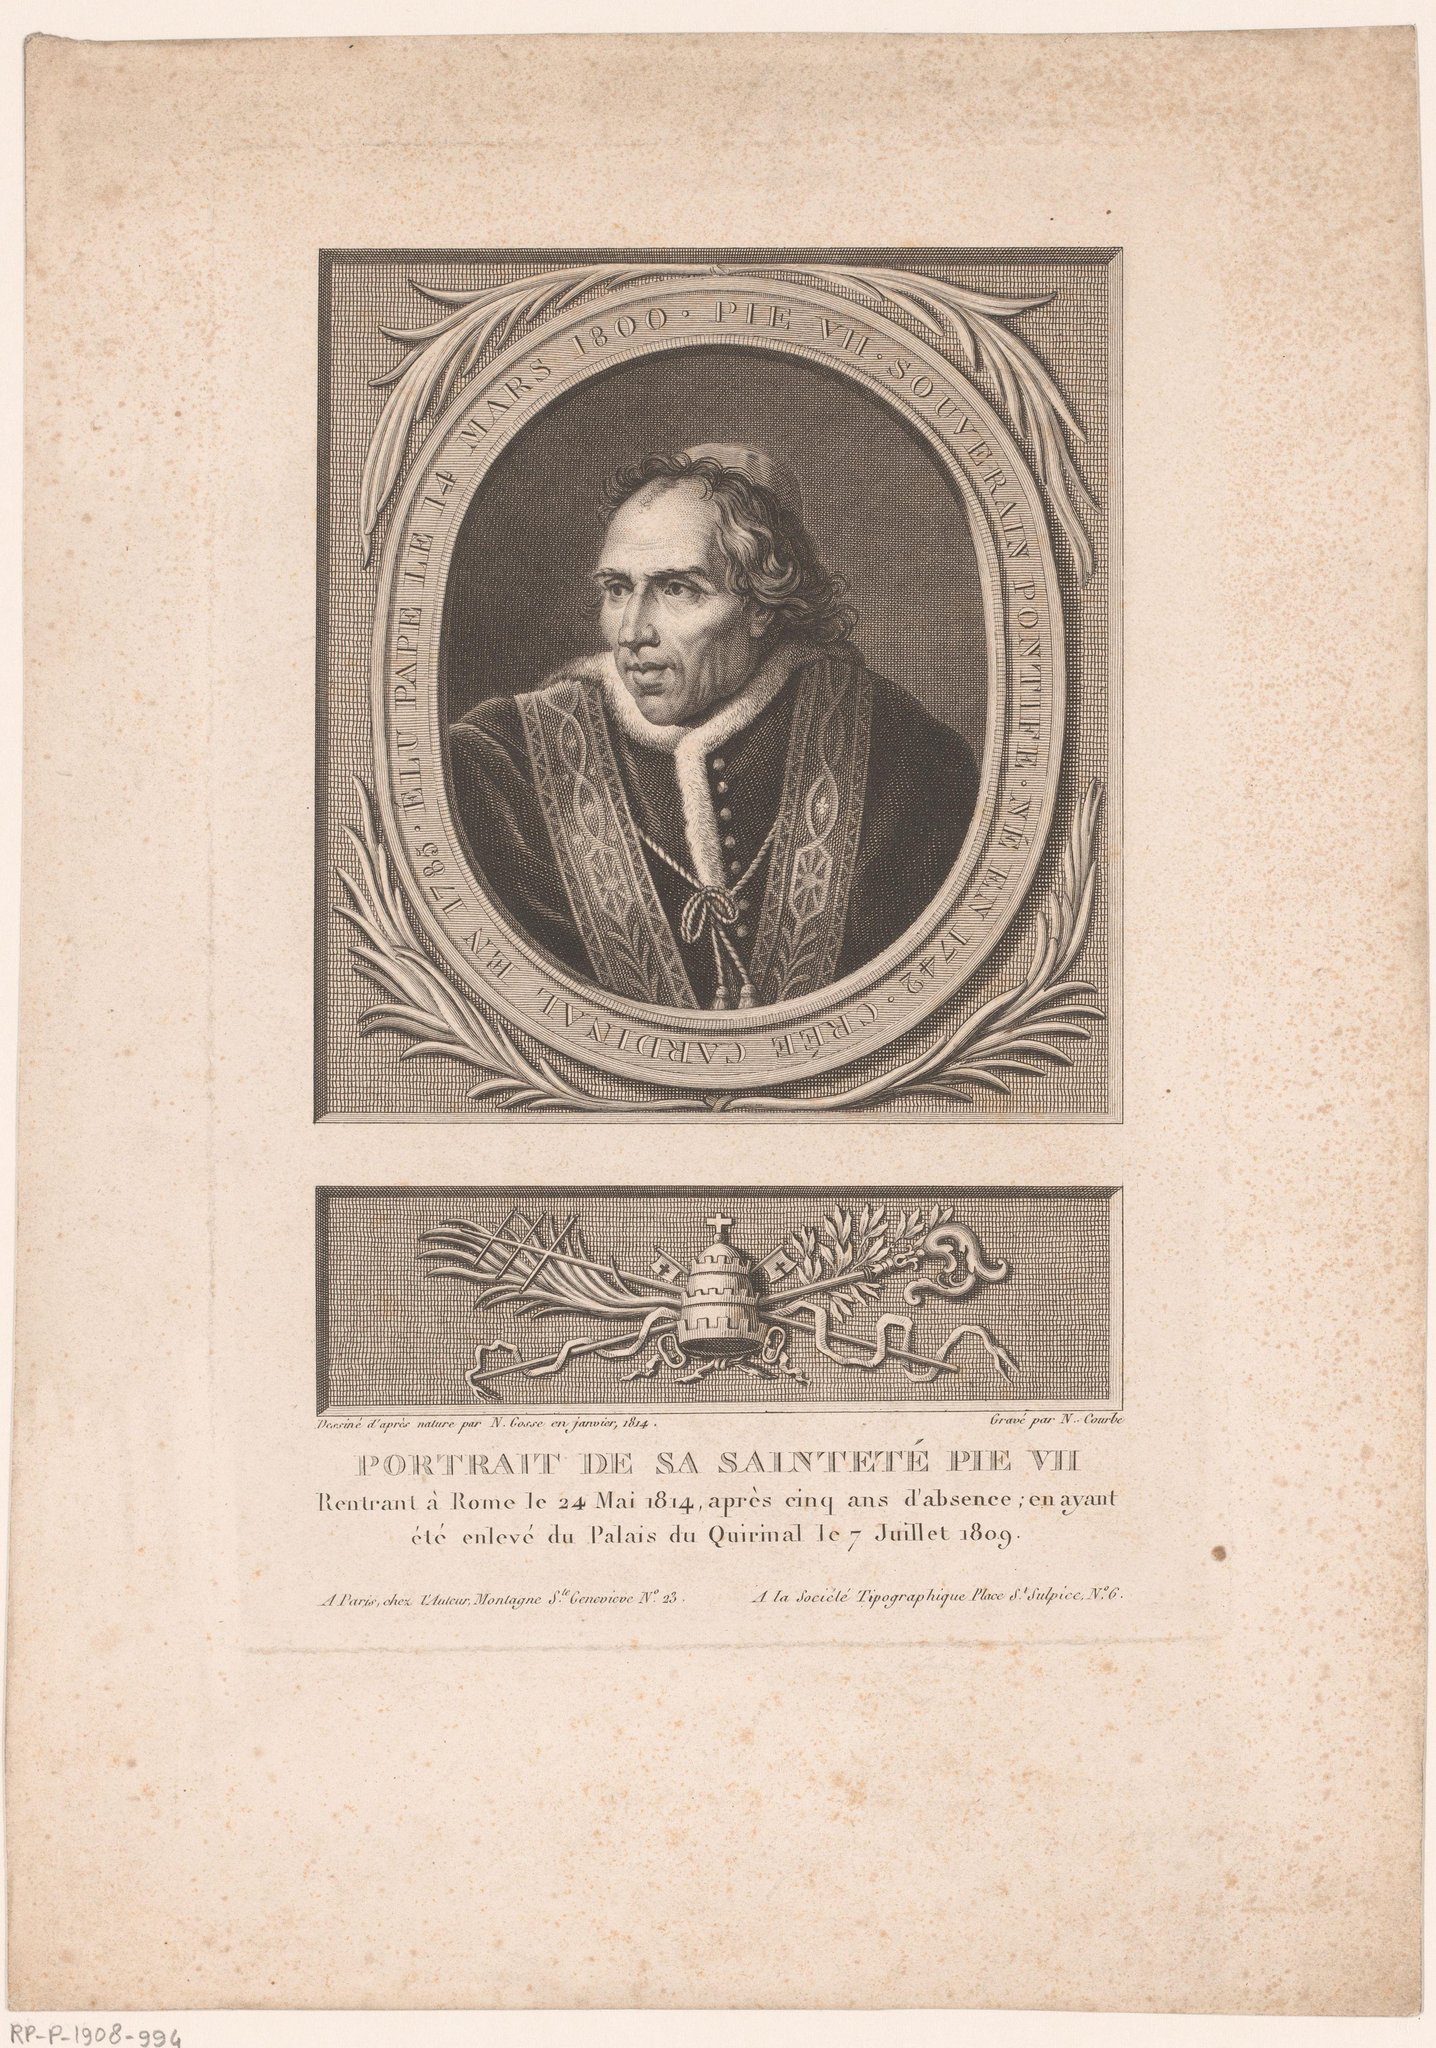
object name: print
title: Portret van Pius VII in ovaal met onderaan pauselijk insignia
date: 1814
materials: paper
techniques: etching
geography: paris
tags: rome, clergyman, pius vii, insignia of the pope, e.g. tiara, historical persons, pope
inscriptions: collector's mark: Lugt 2228